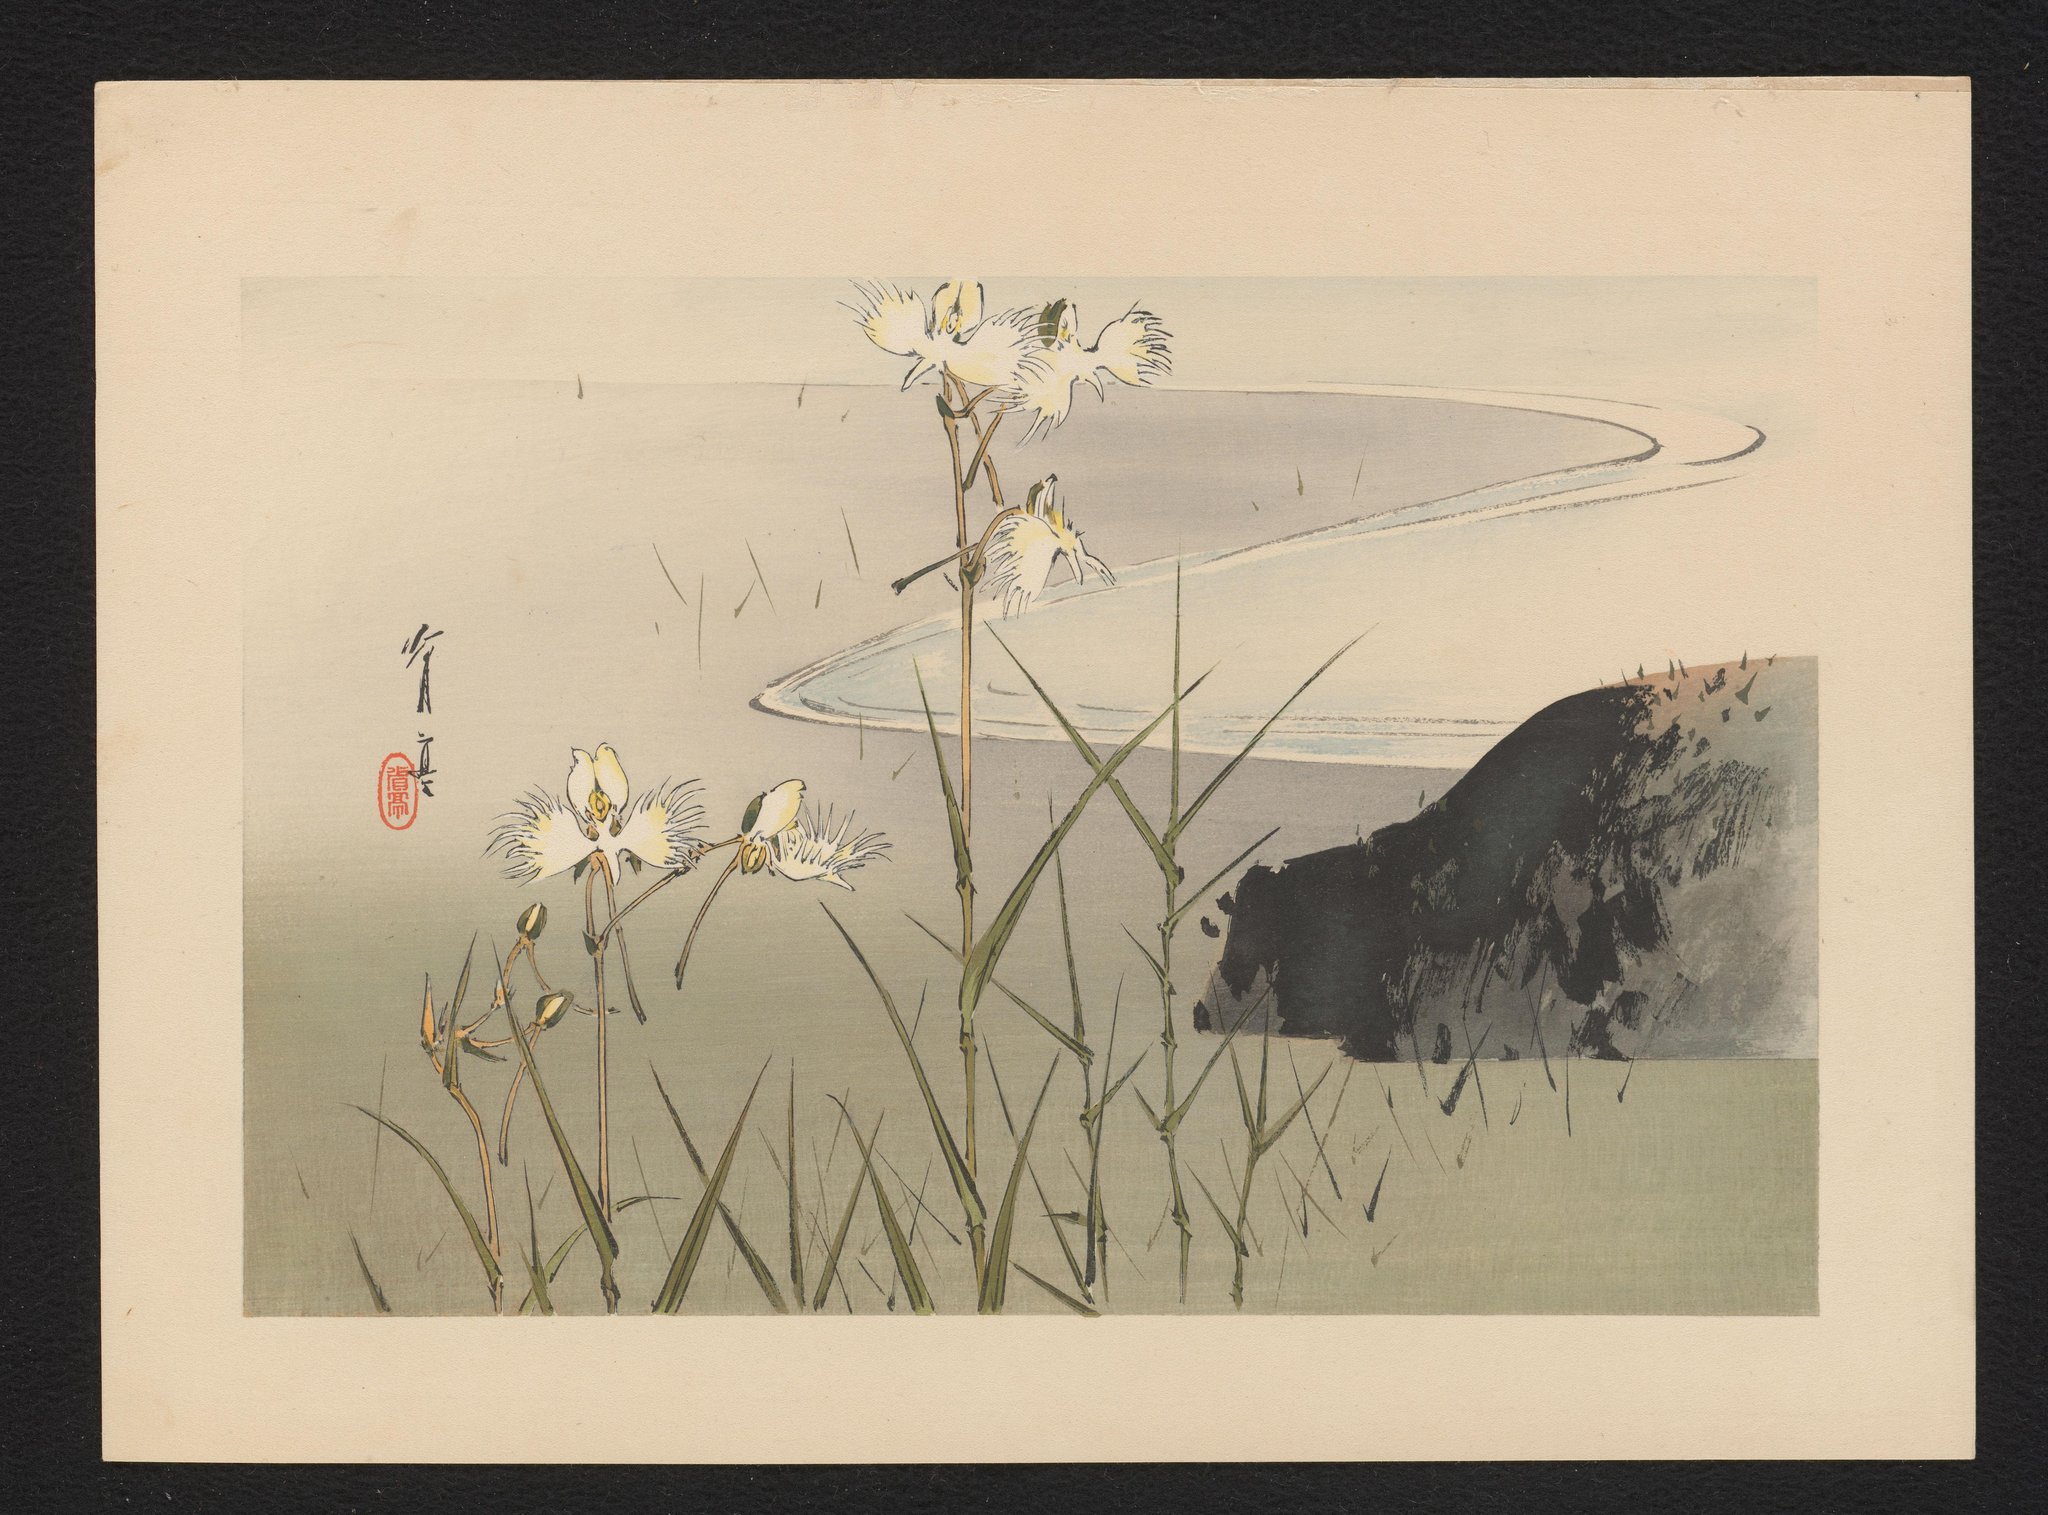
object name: print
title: Bloeiend riet aan waterkant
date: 1916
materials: paper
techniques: woodcut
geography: japan